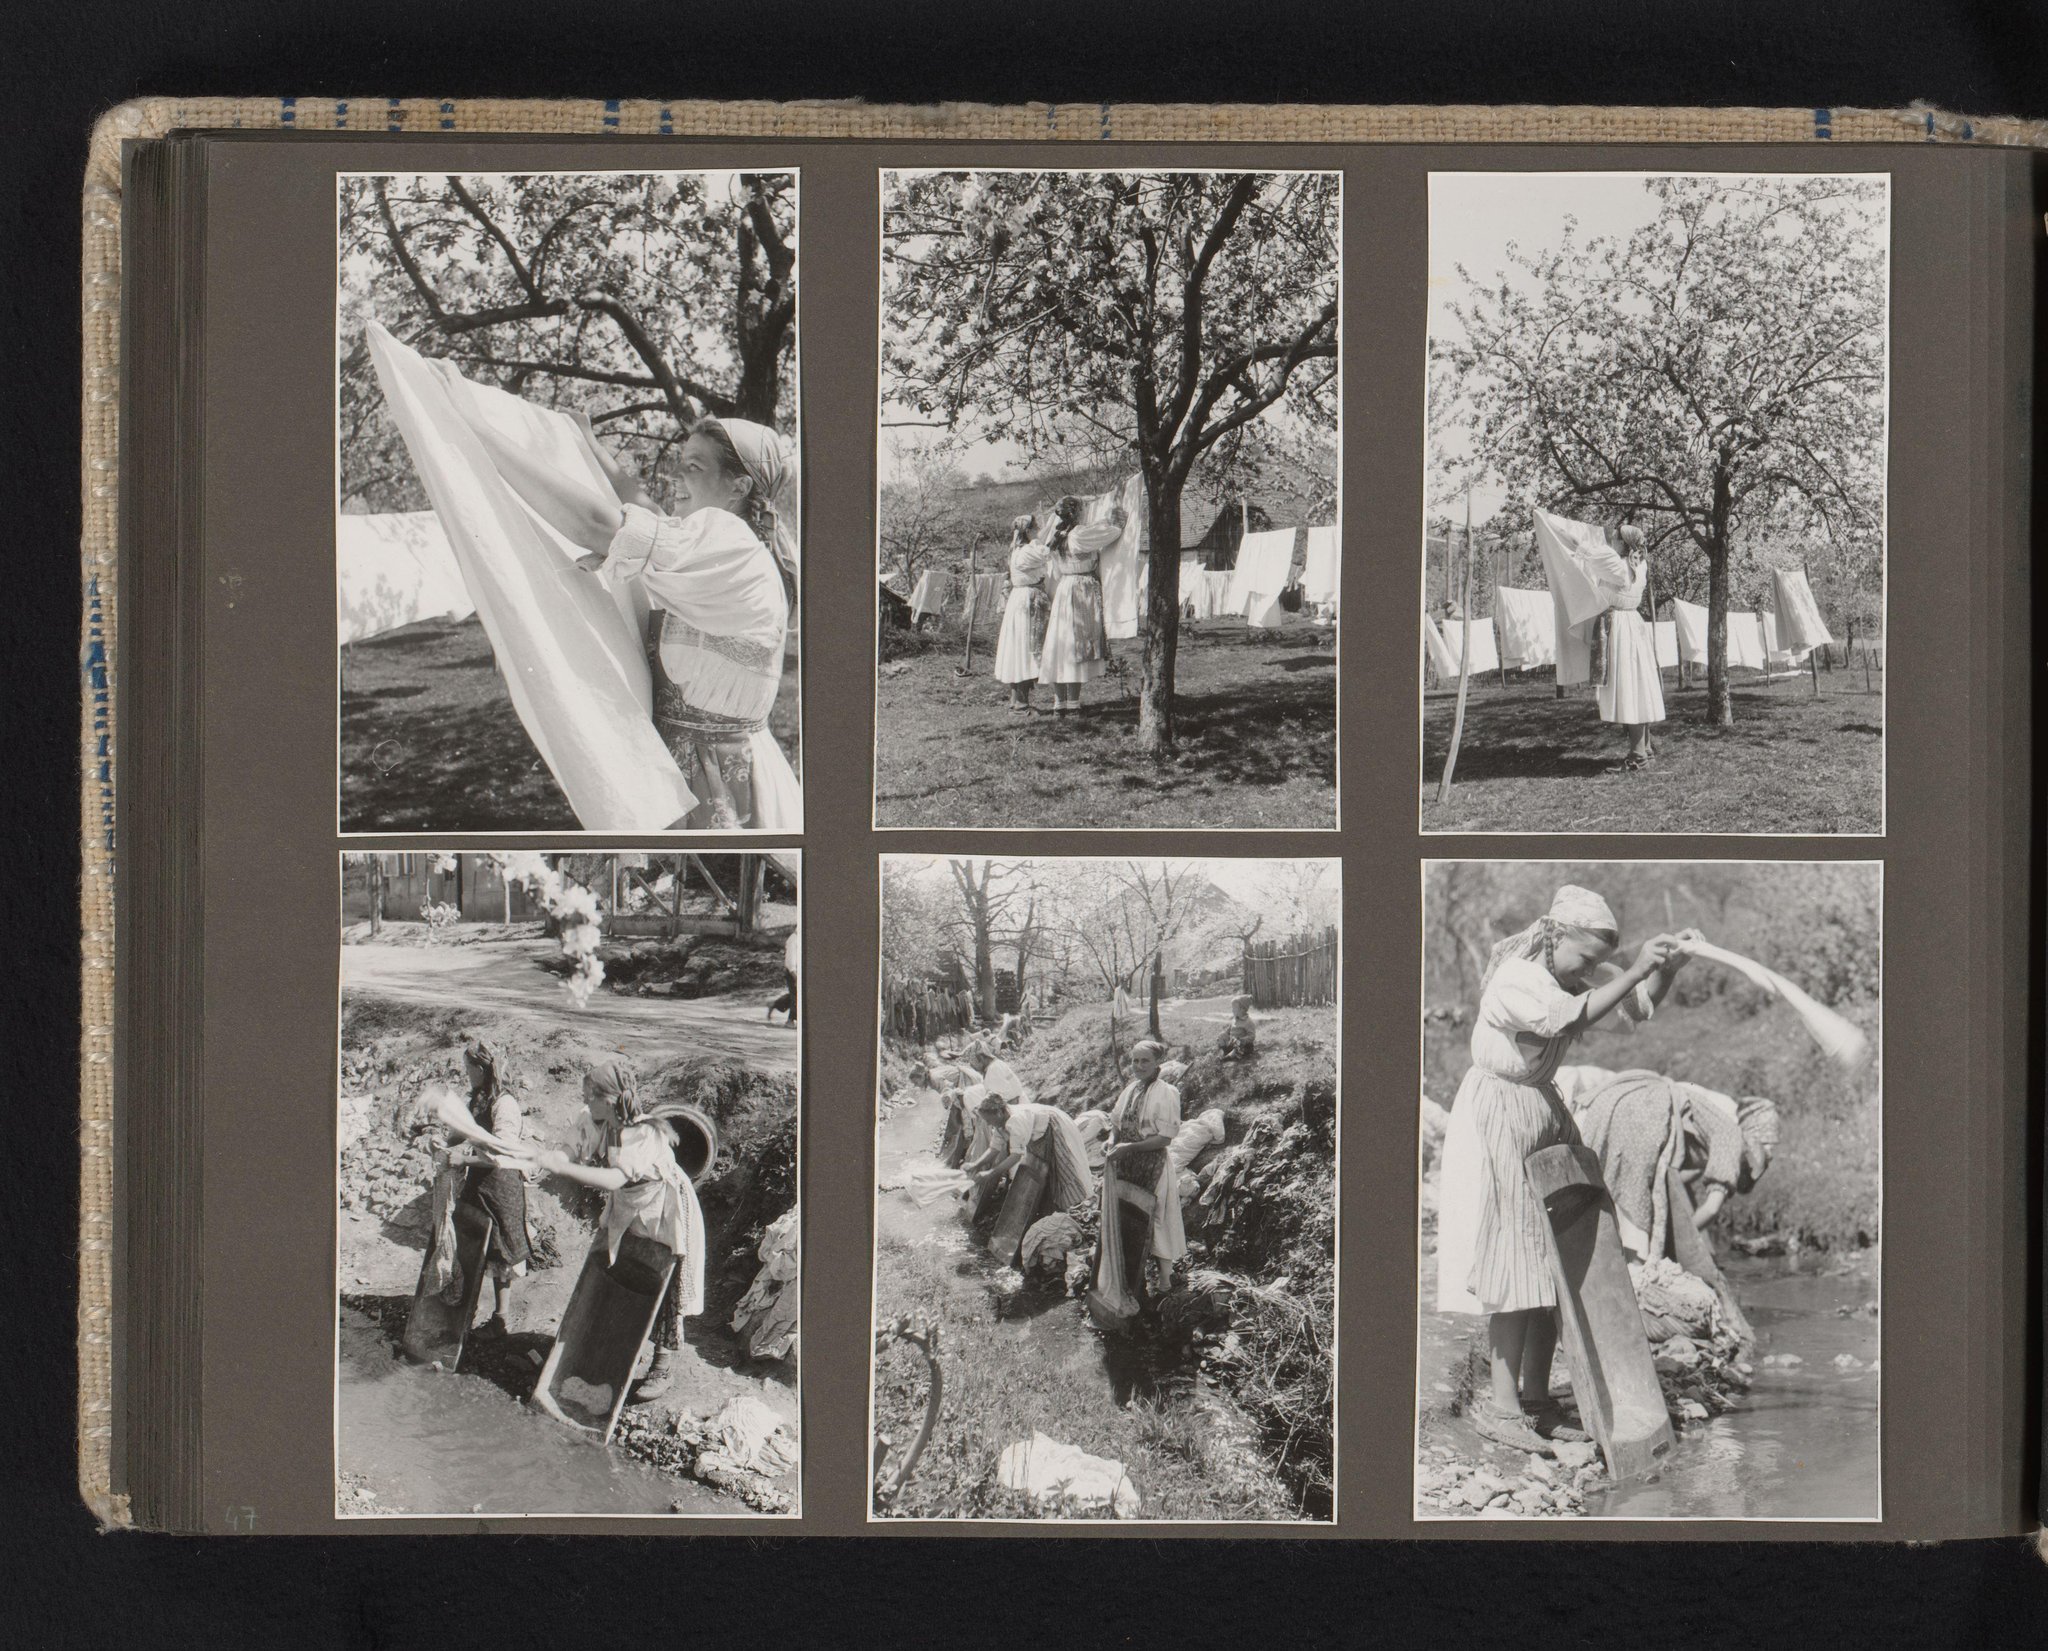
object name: photograph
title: Joegoslavië, april 1943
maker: Anonymous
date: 1904-1943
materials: cardboard, photographic support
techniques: gelatin silver print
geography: yugoslavia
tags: laundering, folk costume, regional costume, occupation ~ war, hanging the wash to dry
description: Albumblad met zes foto's in Joegoslavië, waarschijnlijk april 1943: vrouwen in lokale dracht die de was doen in een rivier en het wasgoed ophangen in de buitenlucht in een boomgaard. Onderdeel van het fotoalbum Abrechnungsintendantur van de Wehrmacht 1941-1943.